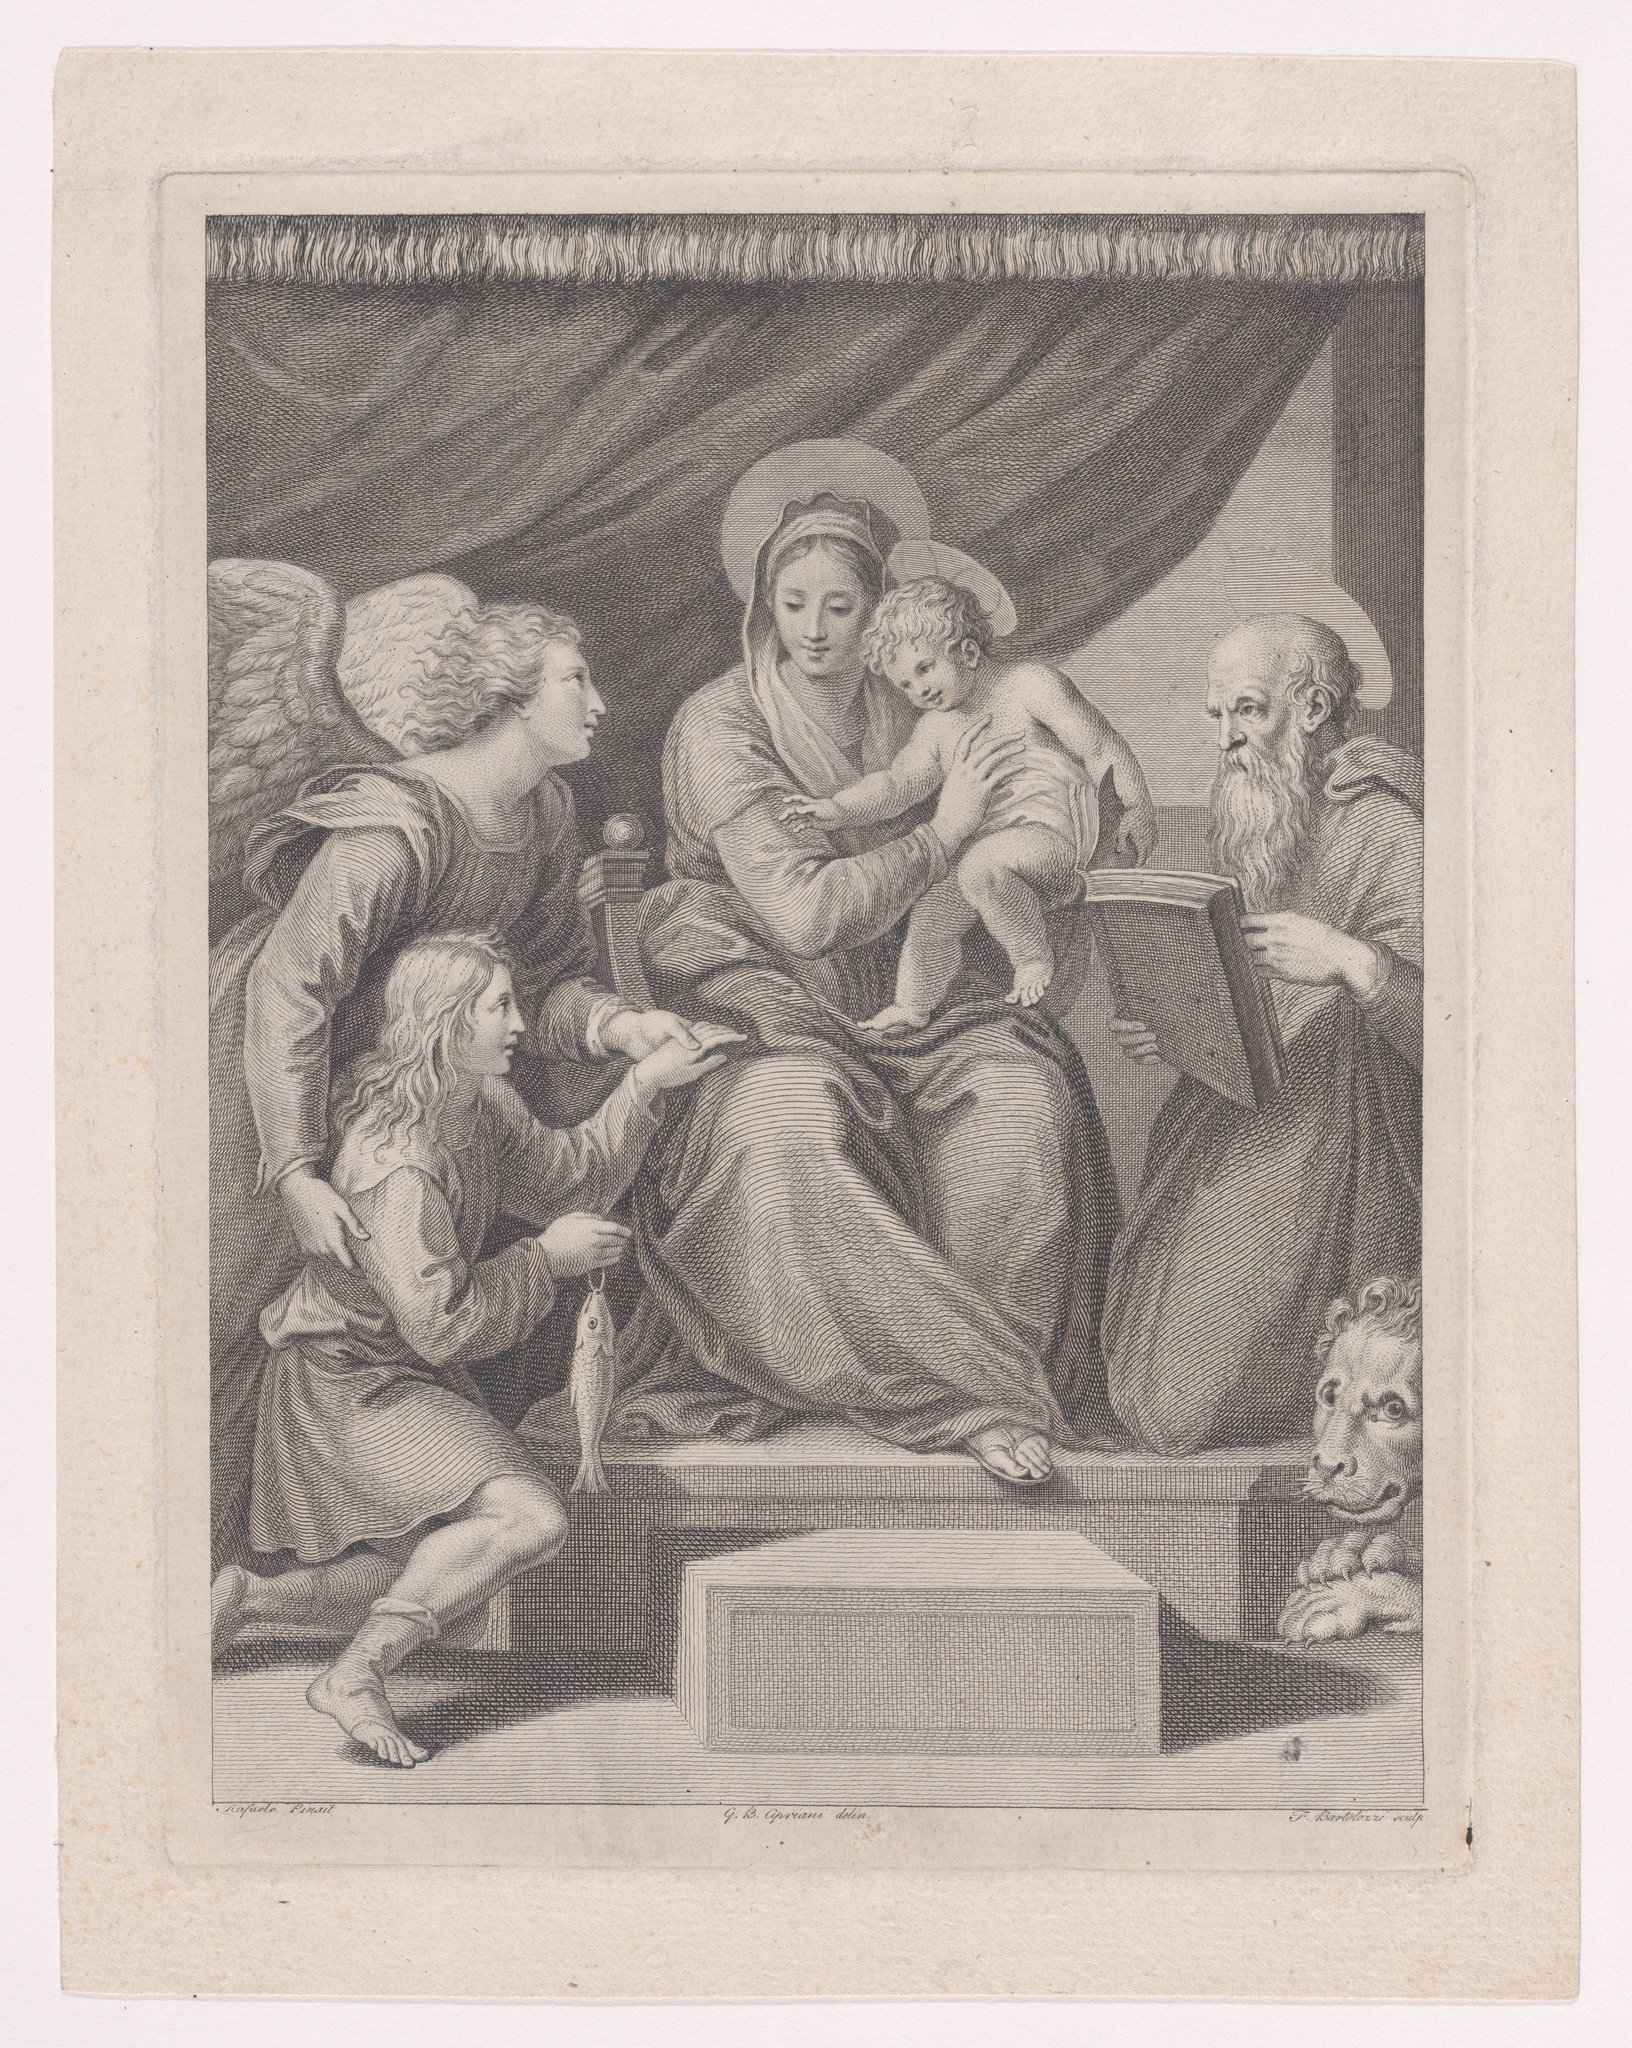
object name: print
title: The Virgin with the Fish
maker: francesco bartolozzi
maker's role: artist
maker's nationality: italian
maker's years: 1728-1815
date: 1775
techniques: engraving, etching